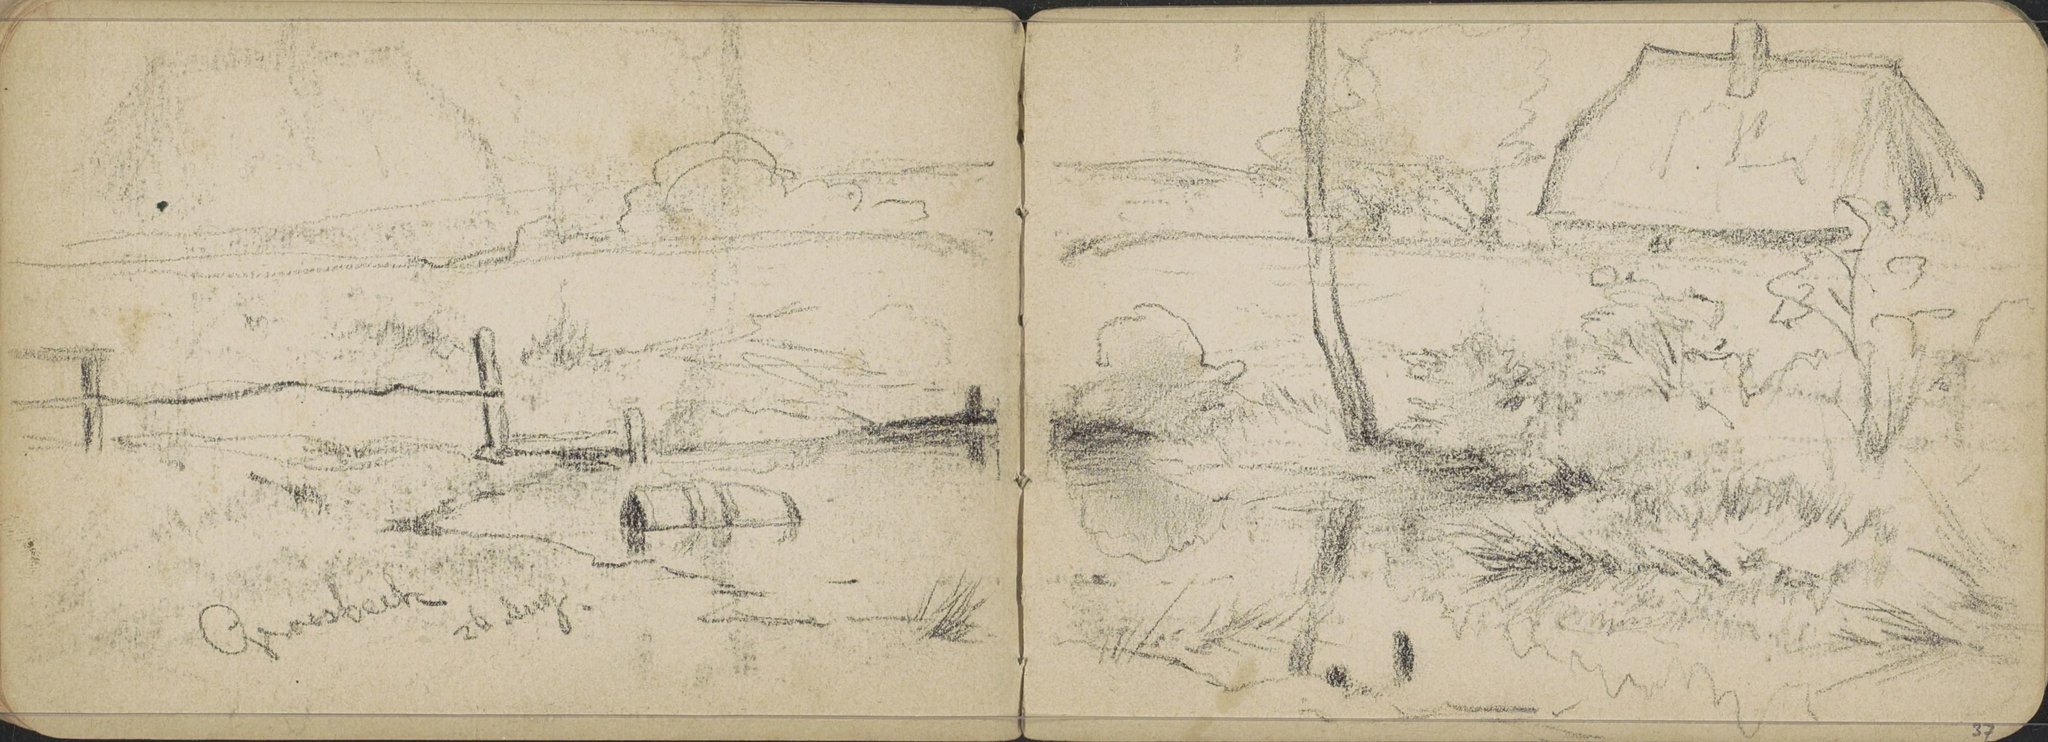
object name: sketchbook leaf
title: Weilanden rondom een boerderij bij Groesbeek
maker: willem cornelis rip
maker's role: draughtsman, painter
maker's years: 1856-1922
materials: chalk, paper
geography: groesbeek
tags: meadow, pasture, farm or solitary house in landscape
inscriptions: date and inscription: ‘Groesbeek/ 26 Aug.’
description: Blad 36 verso en 37 recto uit een schetsboek met 44 bladen.